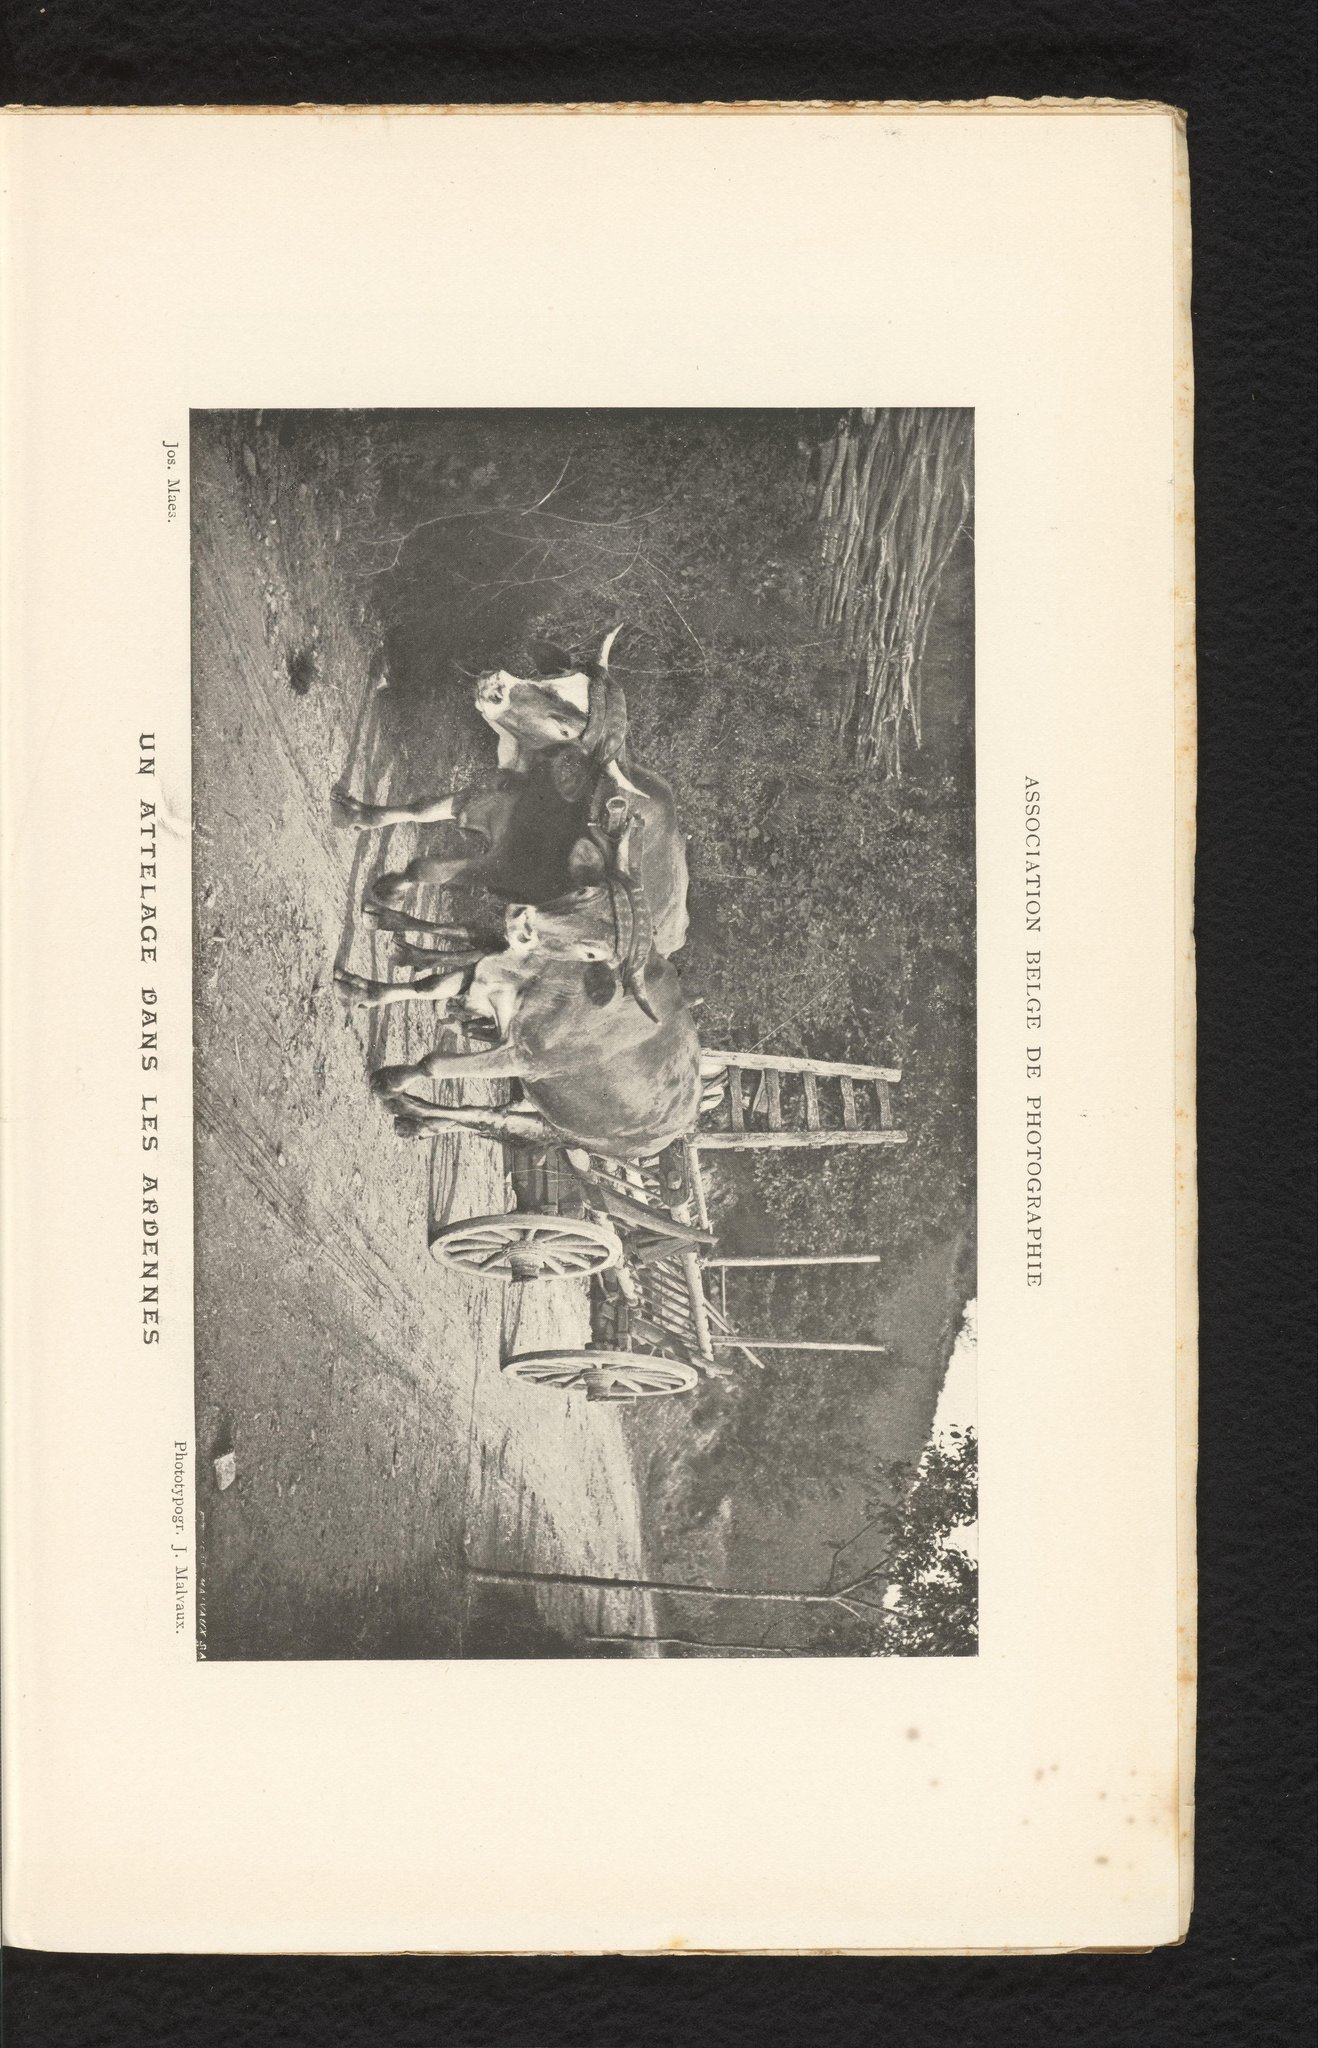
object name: photomechanical print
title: Un Attelage dans les Ardennes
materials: paper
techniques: autotype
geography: nancy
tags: bovine cattle, two-wheeled vehicle drawn by two animals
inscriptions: inscription: ‘ASSOCIATION BELGE DE PHOTOGRAPHIE’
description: Prent op derde ongenummerde pagina na pagina XVI.